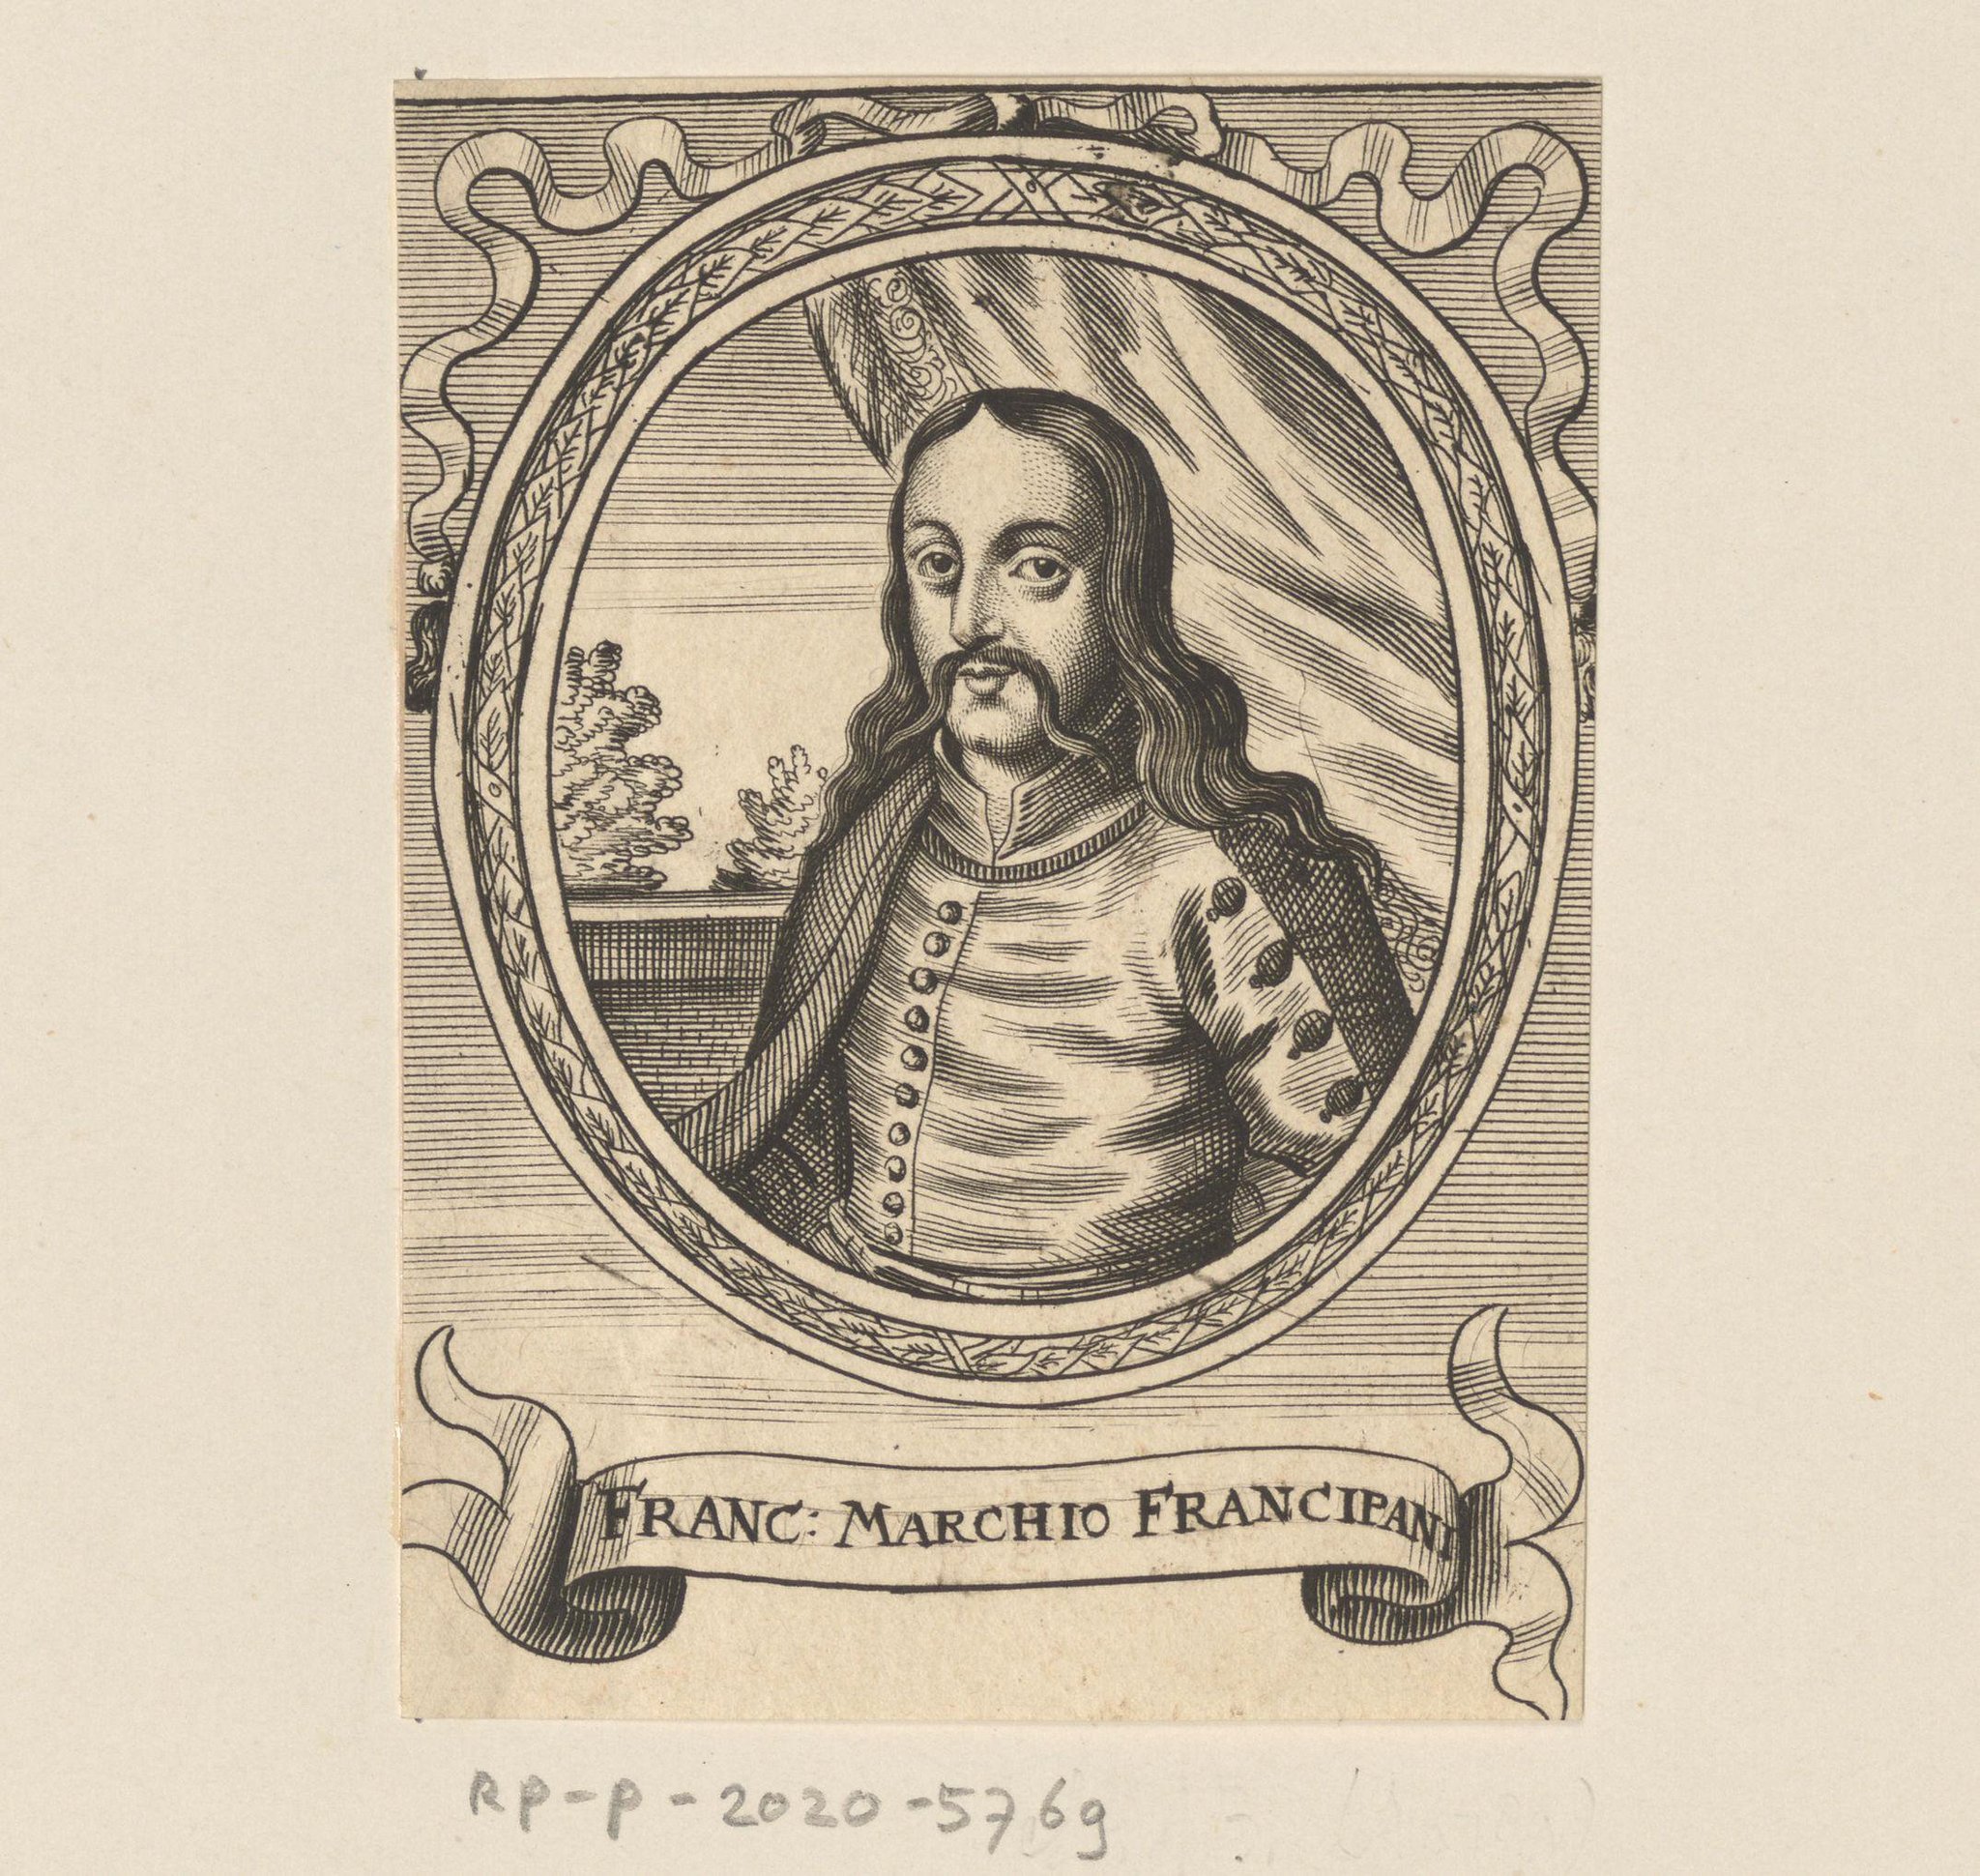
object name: print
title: Franc: Marchio Francipani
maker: Anonymous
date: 1670-1750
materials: paper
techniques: engraving, etching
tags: politician, ornament ~ medallion, historical persons, portrait of a writer